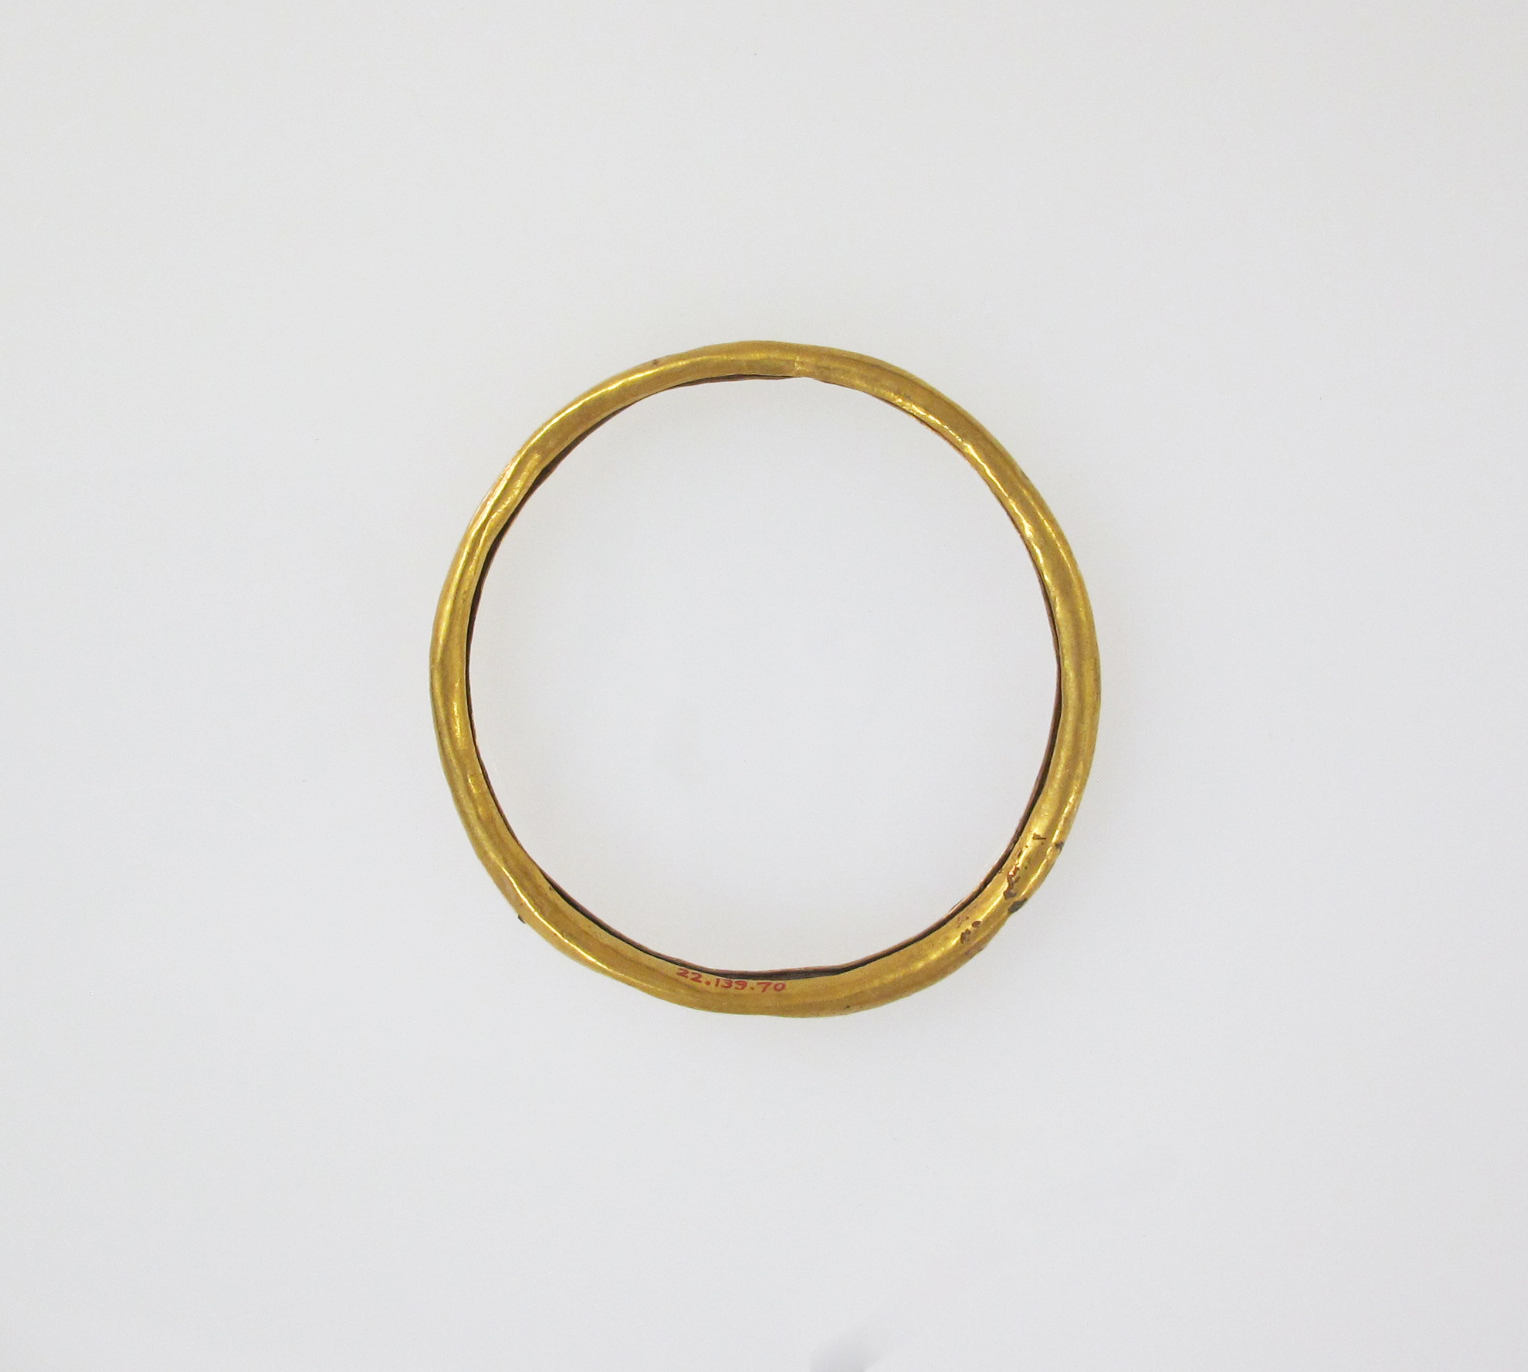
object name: bracelet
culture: roman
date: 101-400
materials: gold